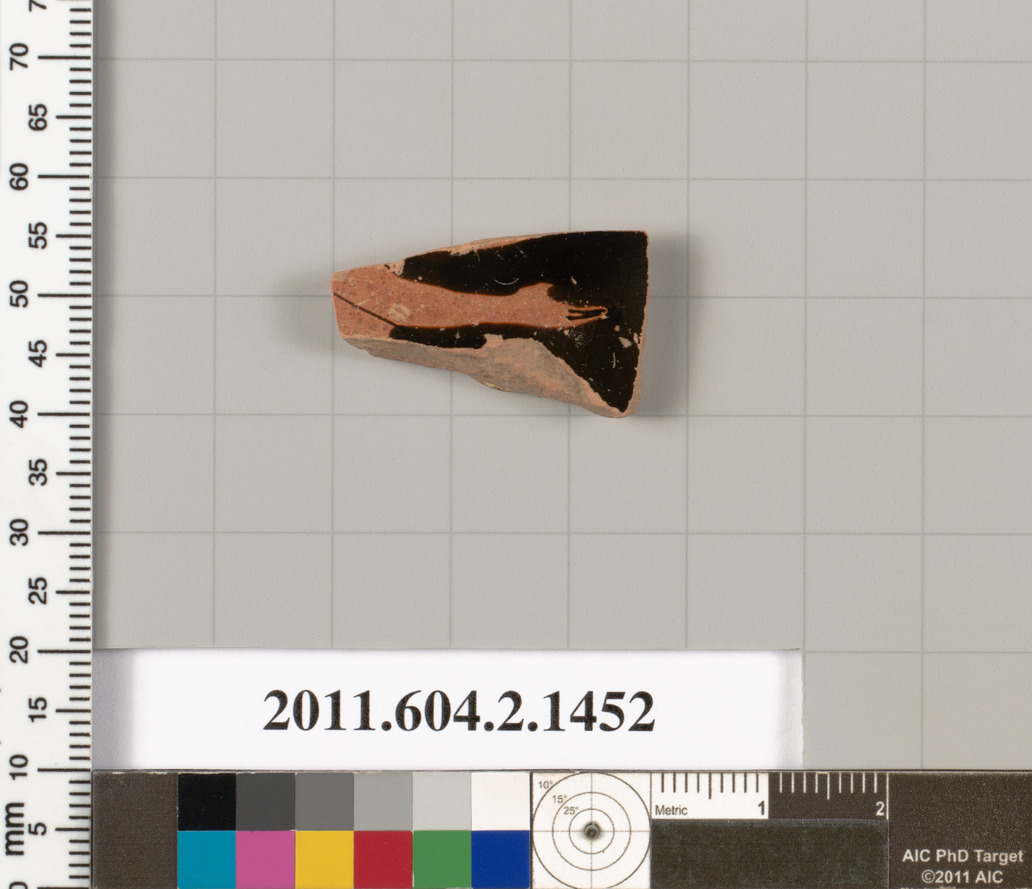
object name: skyphos fragment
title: Terracotta fragment of a skyphos (deep drinking cup)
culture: greek, attic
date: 475-451 BCE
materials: terracotta